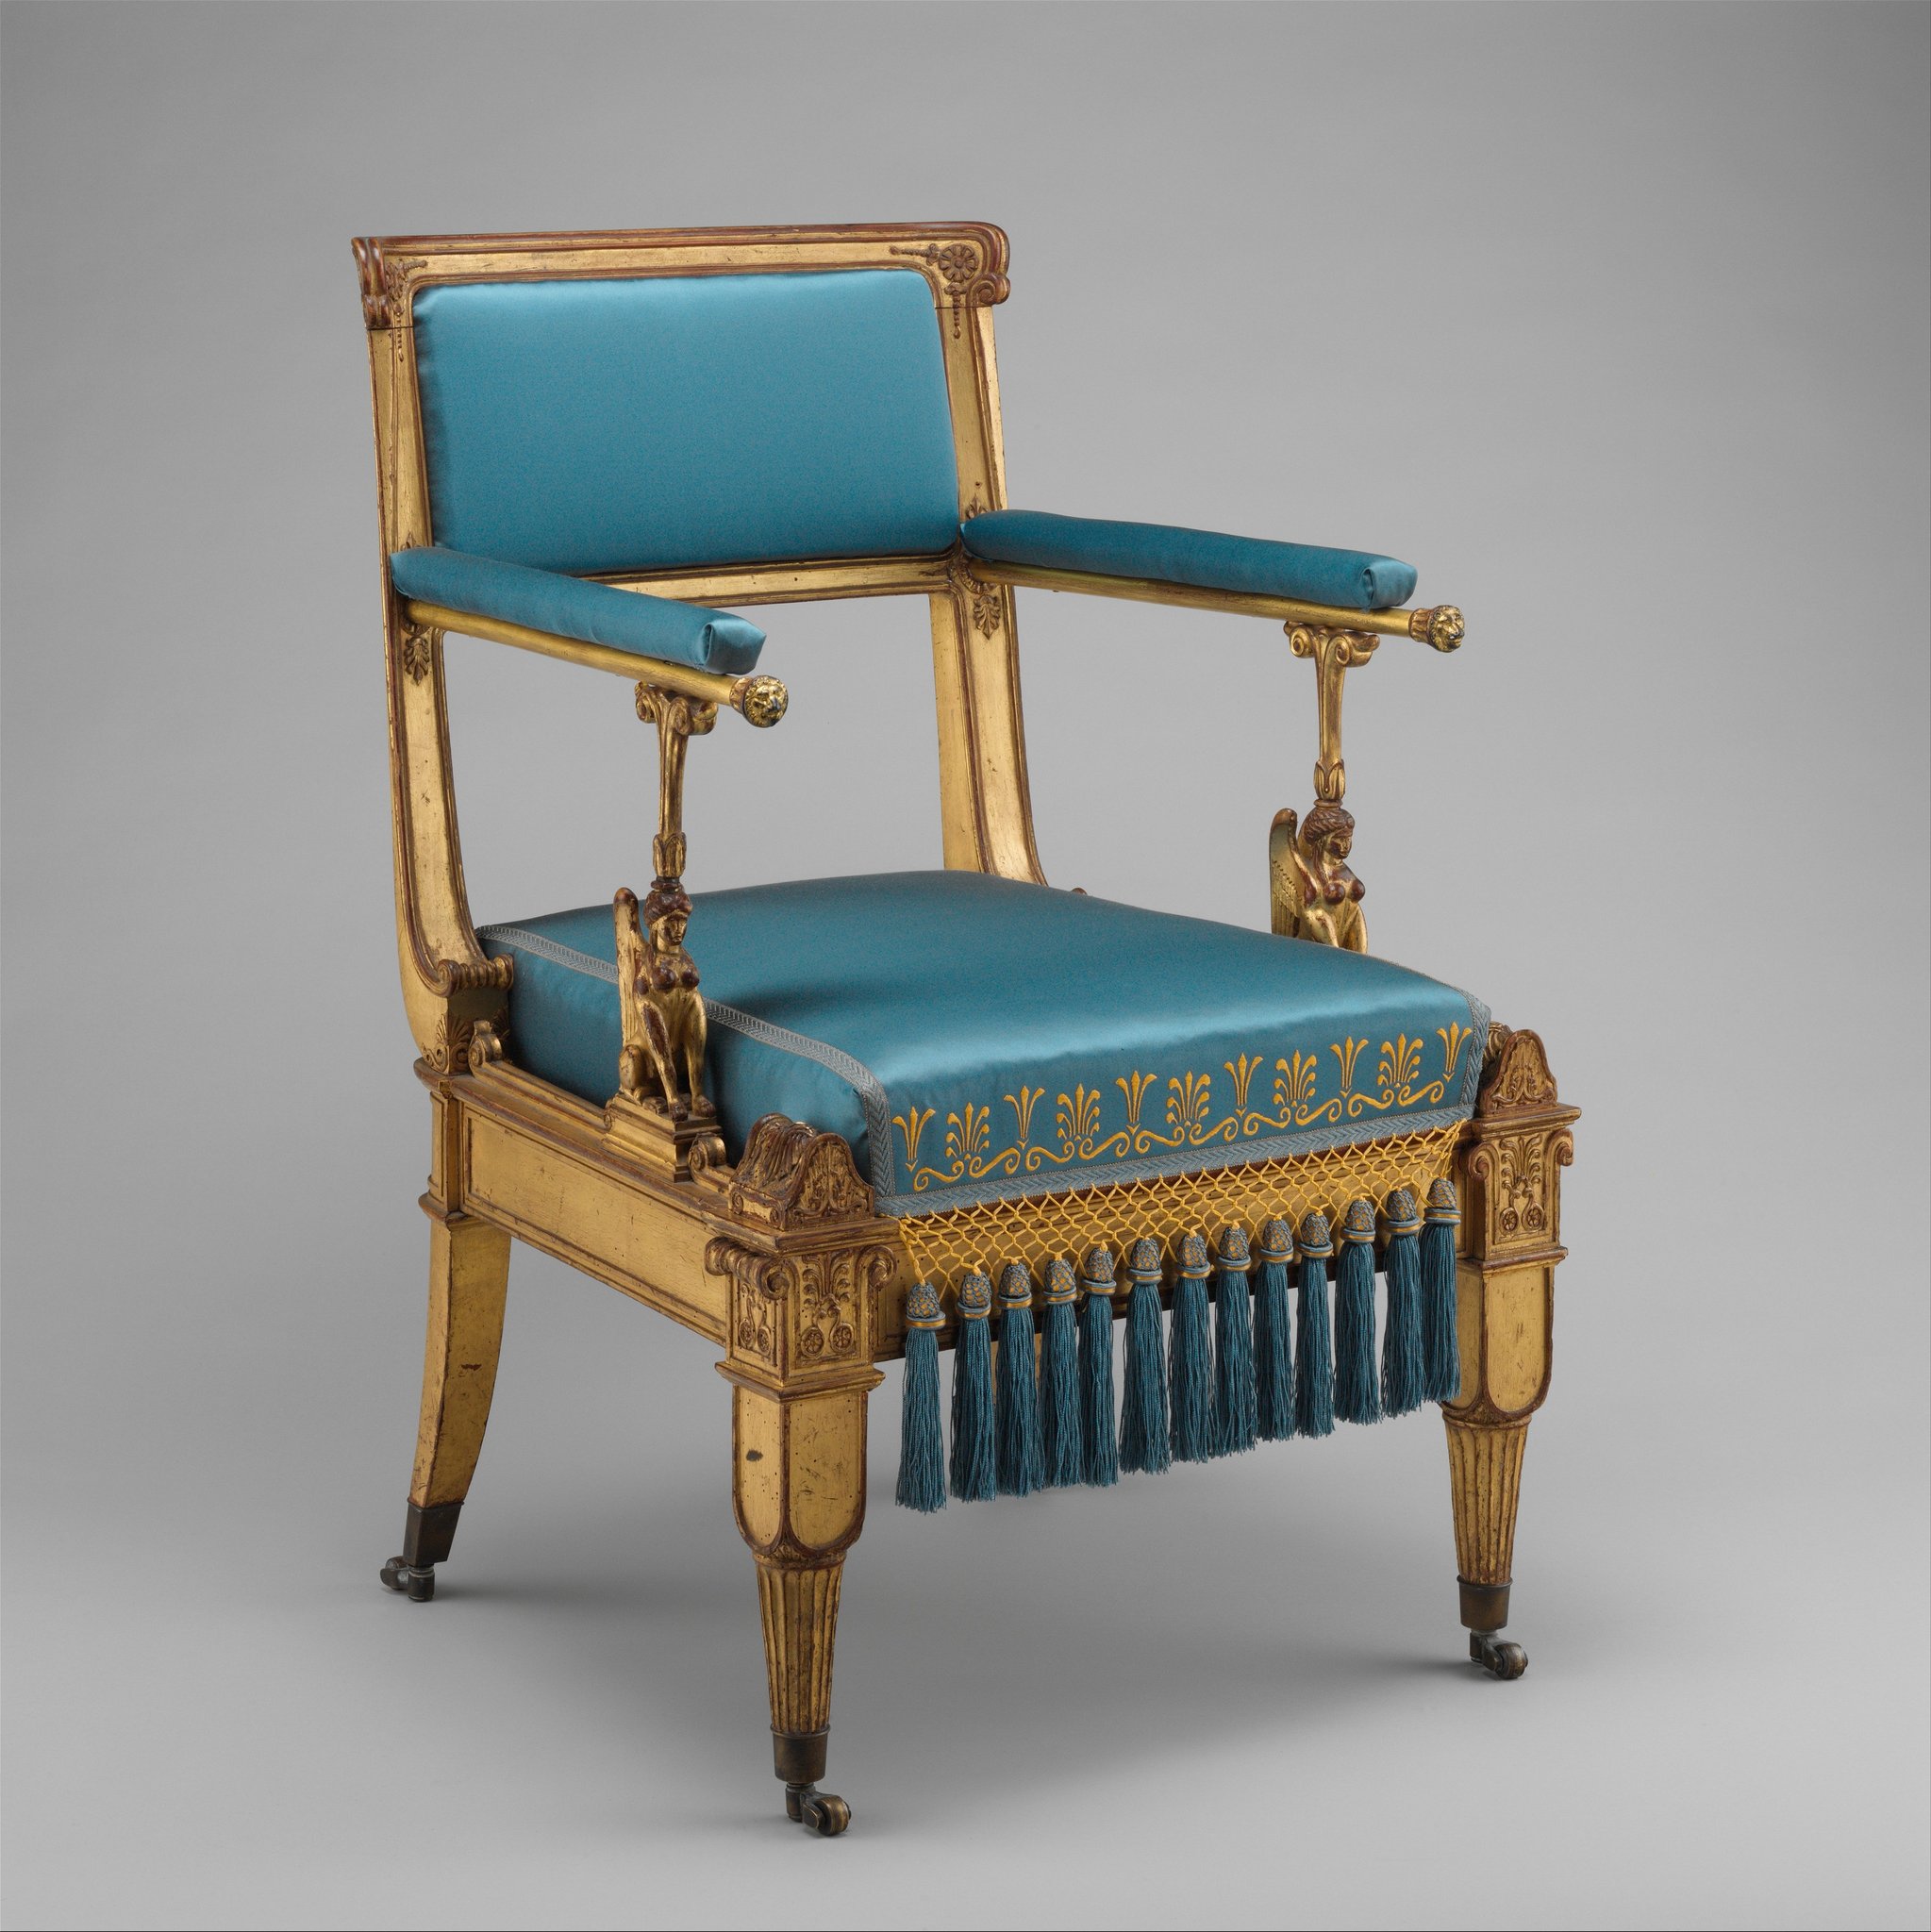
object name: armchair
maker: karl friedrich schinkel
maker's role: artist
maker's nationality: german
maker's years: 1781-1841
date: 1828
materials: wood, brass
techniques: gilding